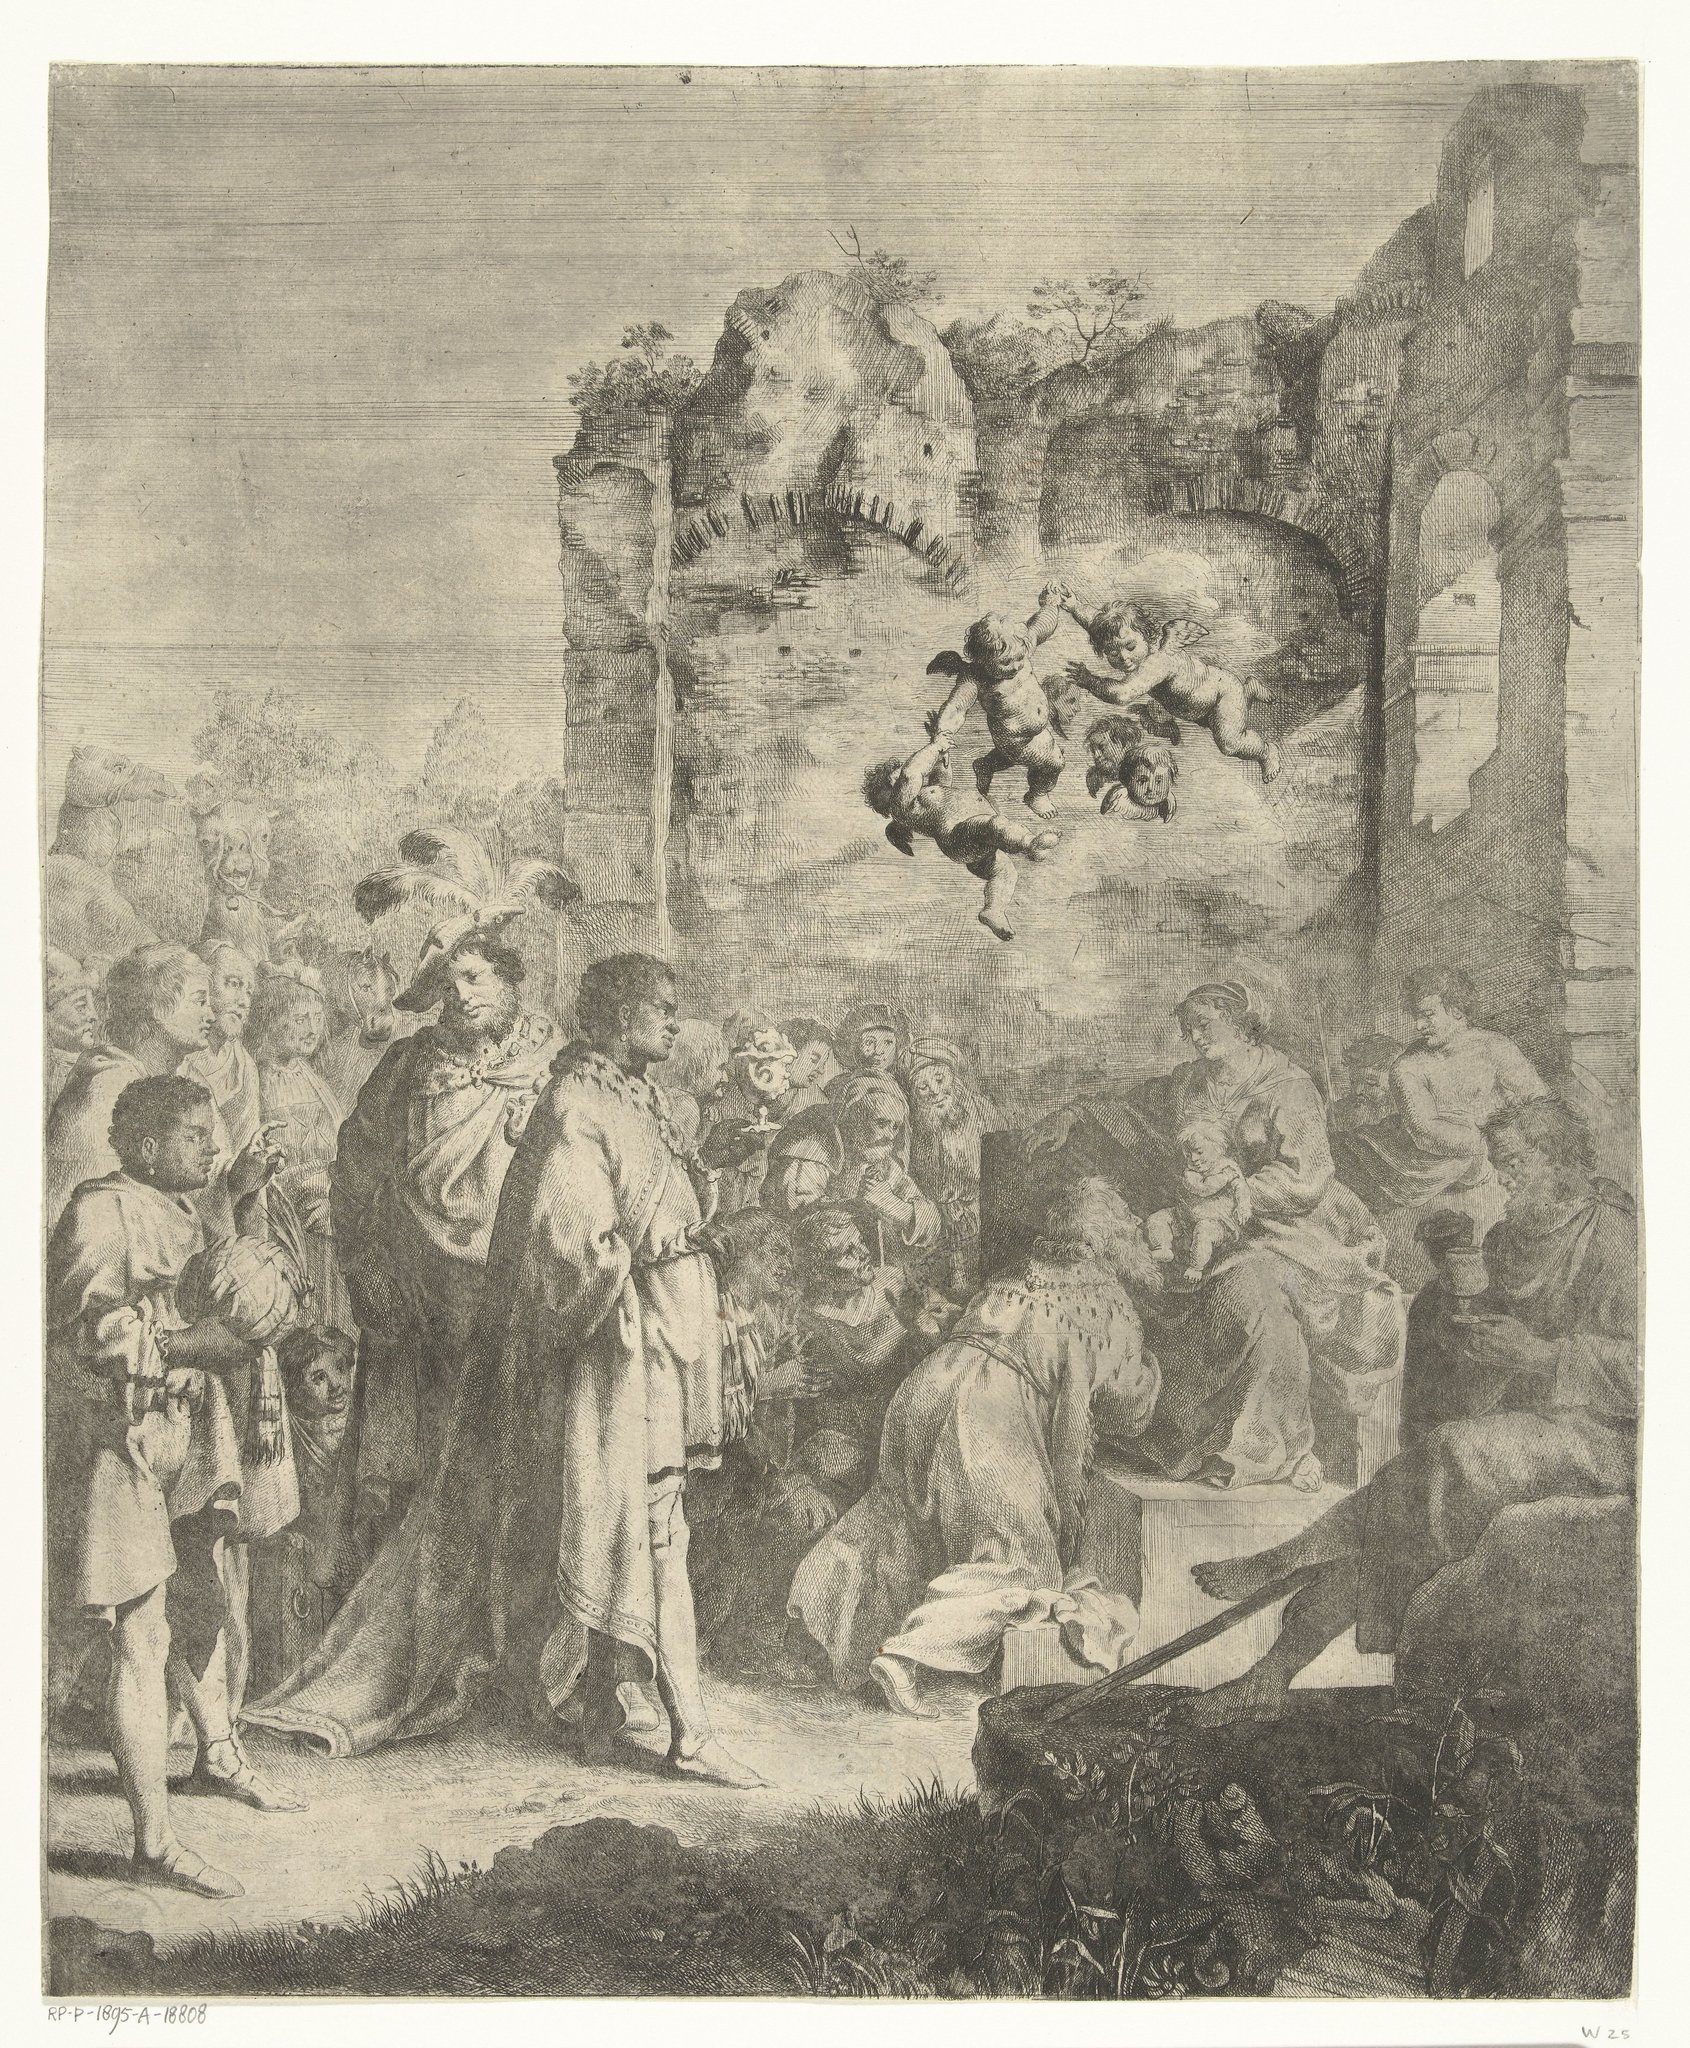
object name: print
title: Aanbidding van de Koningen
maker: jan gerritsz. van bronckhorst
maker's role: draughtsman, painter, print maker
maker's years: 1603-1661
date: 1613-1661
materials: paper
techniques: engraving, etching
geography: netherlands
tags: adoration of the kings: the wise men present their gifts to the christ-child (gold, frankincense and myrrh)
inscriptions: collector's mark: Lugt 514, collector's mark: Lugt 2228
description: Prent naar ontwerp van Cornelis van Poelenburch.